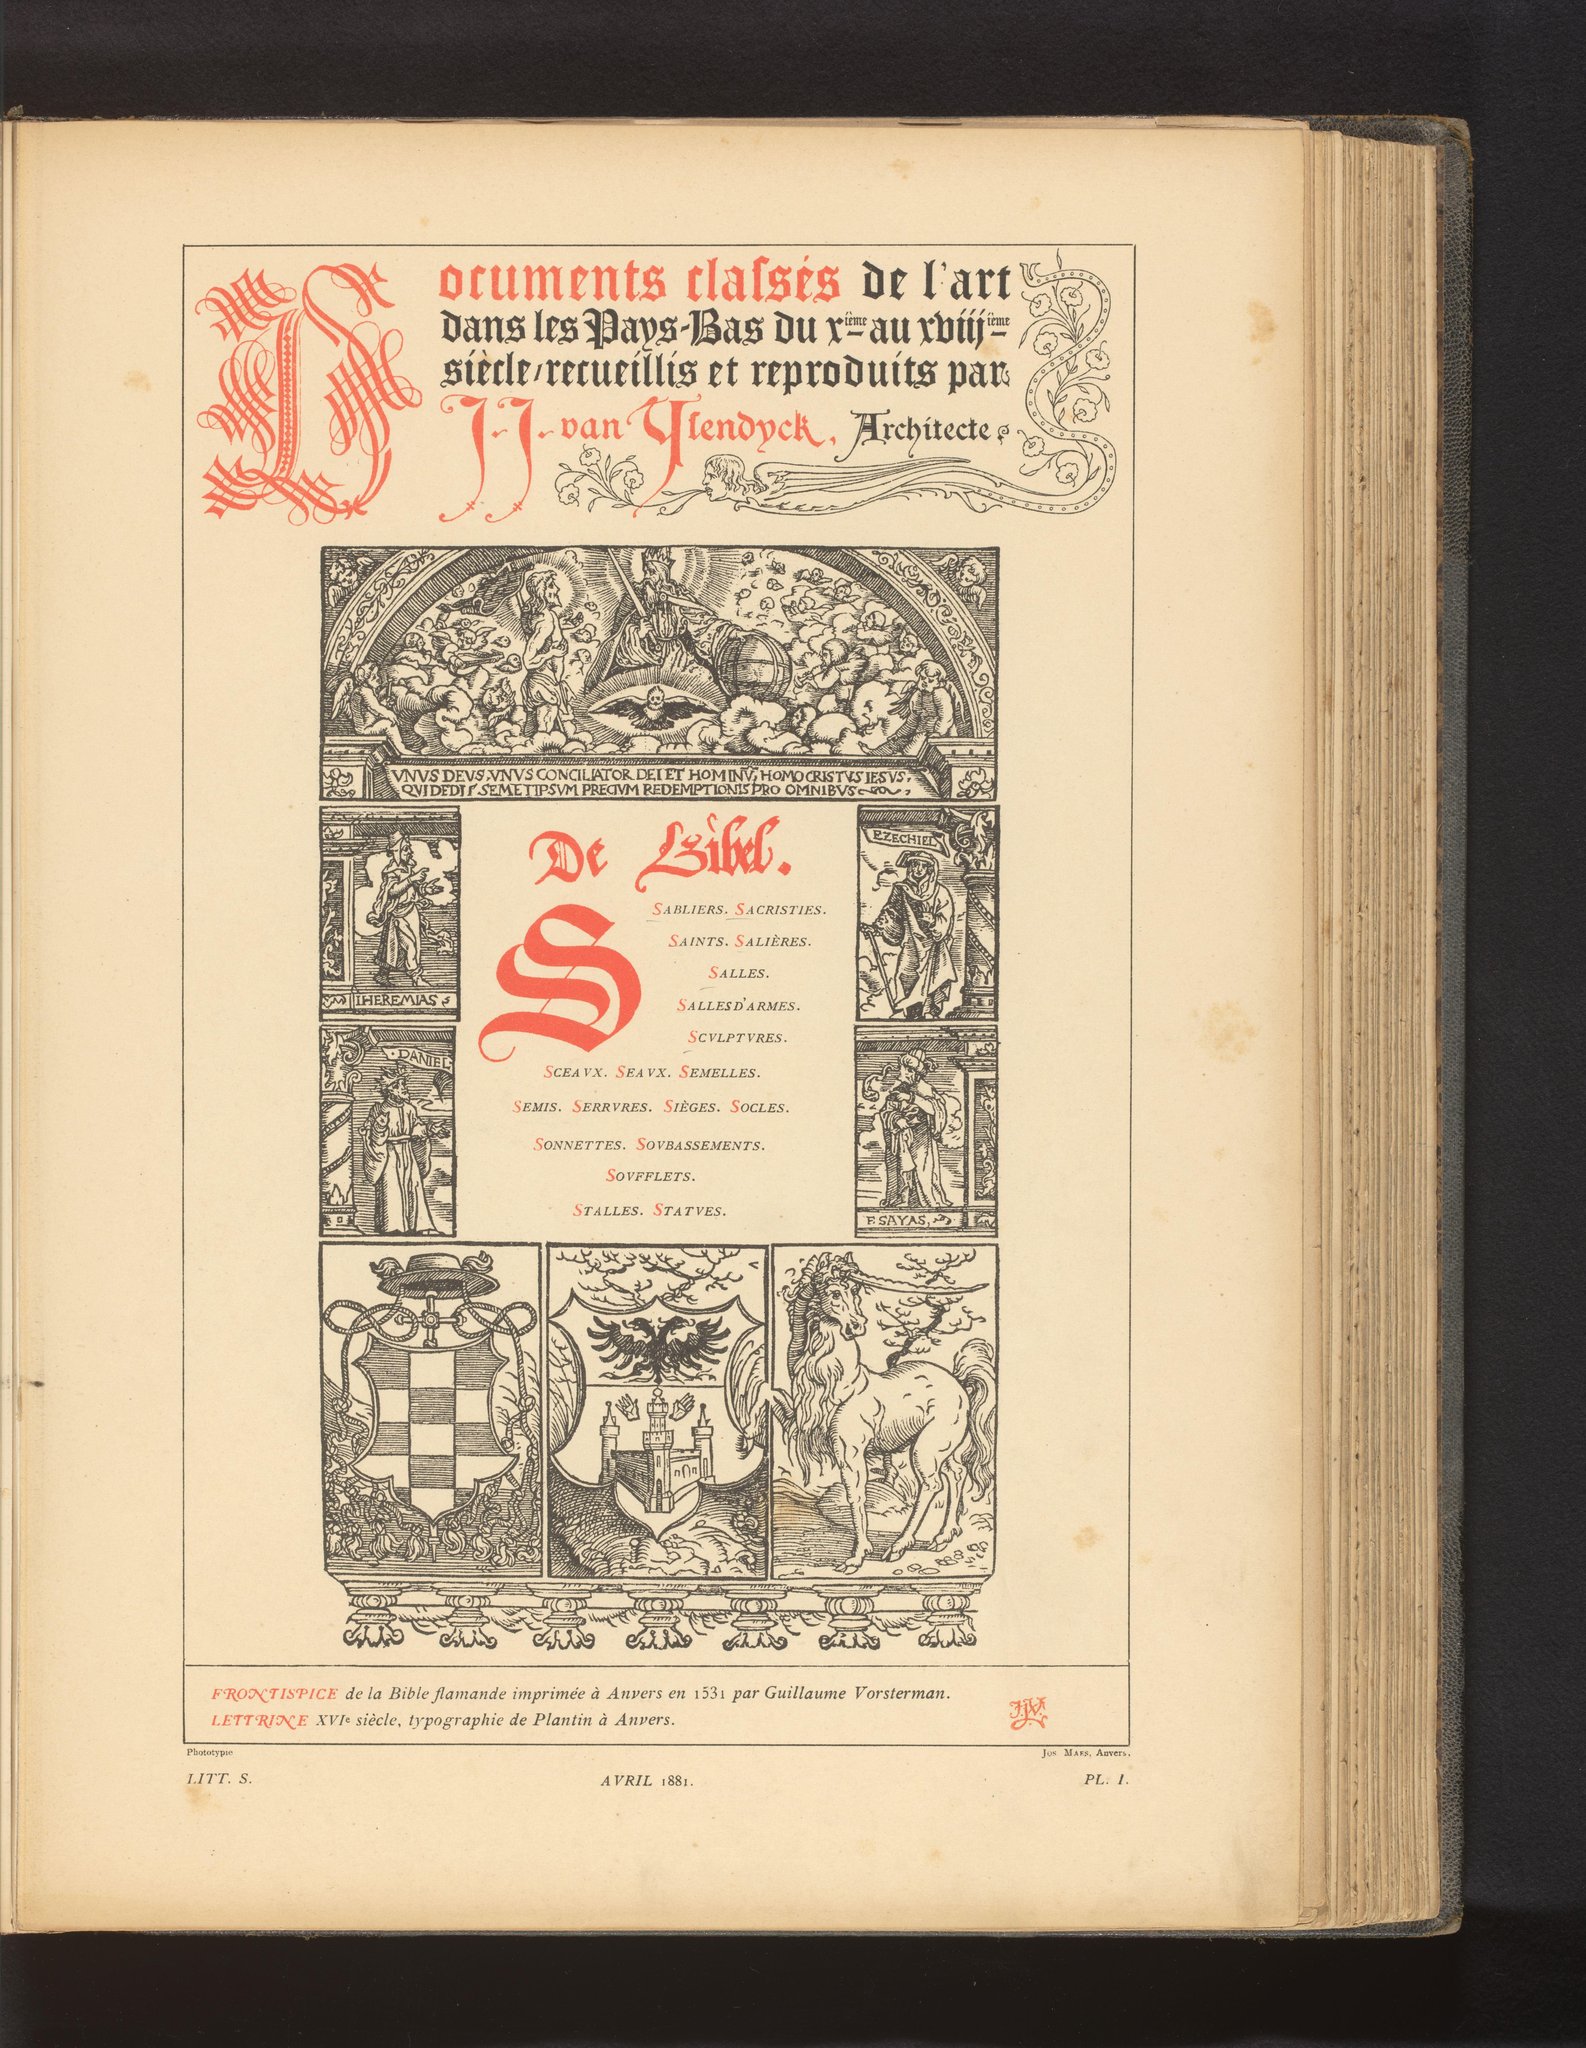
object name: page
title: Reproductie van een titelpagina met Bijbelse voorstellingen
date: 1876-1881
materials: paper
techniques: photolithography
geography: antwerp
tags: title-page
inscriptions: inscription: ‘FRONTISPICE de la Bible (...)’, monogram: ‘JJvY’, inscription: ‘LITT. S. AVRIL 1881. PL. 1’